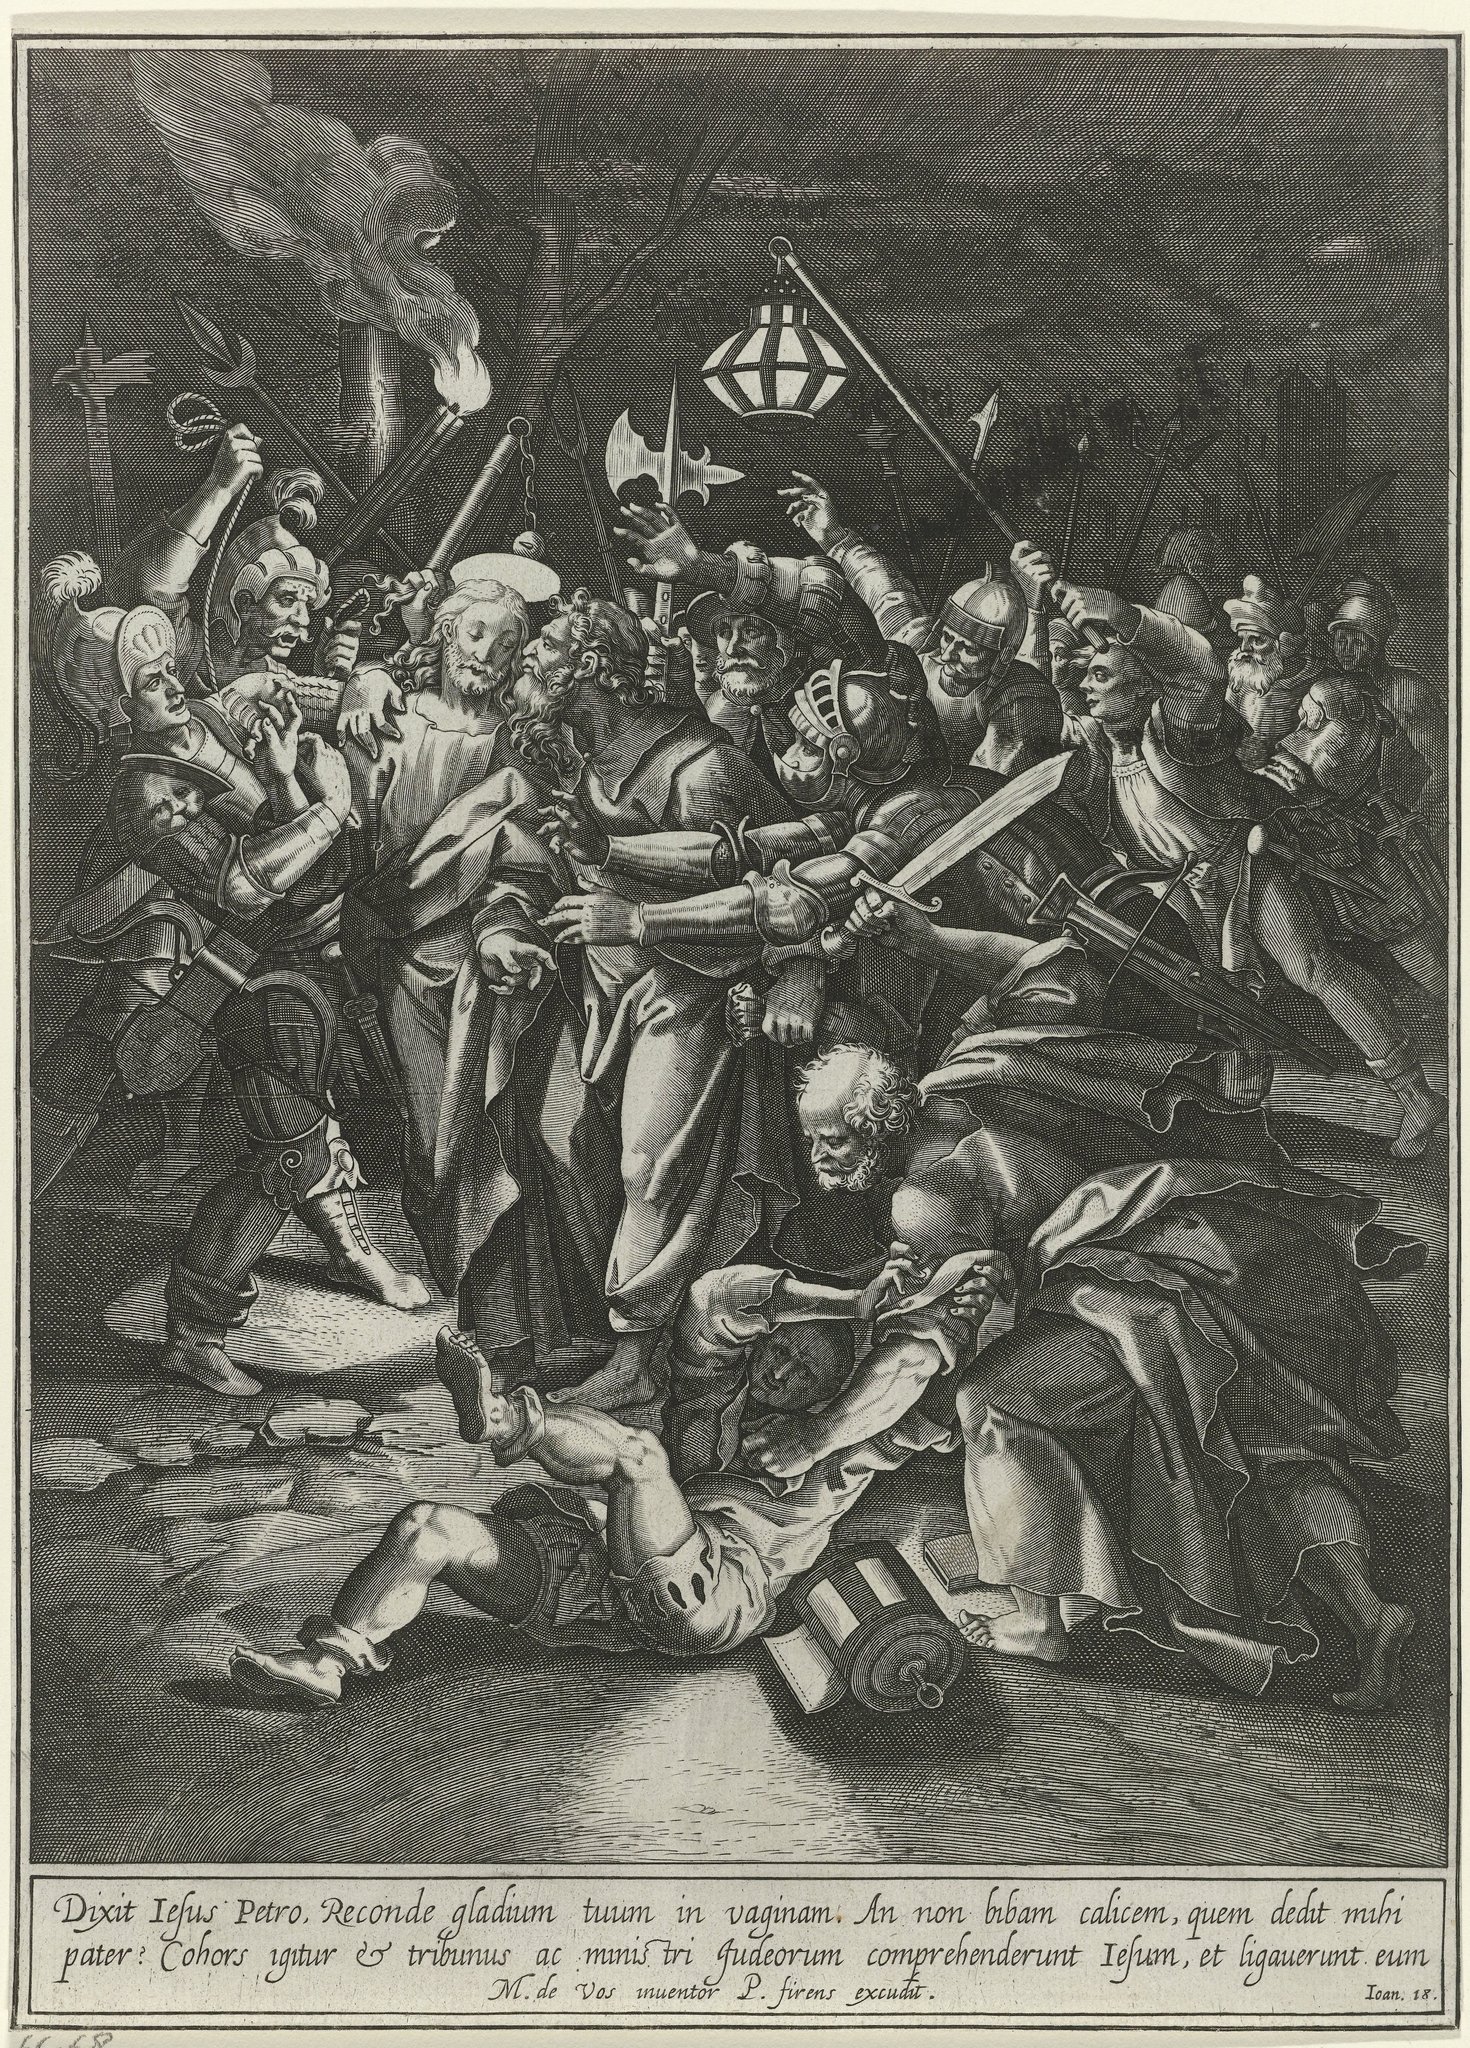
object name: print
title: Passie en wederopstanding van Christus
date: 1590-1638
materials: paper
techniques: engraving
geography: antwerp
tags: the kiss of judas: accompanied by soldiers with torches and lanterns, he kisses christ, the arrest of christ ~ garden of gethsemane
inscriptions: collector's mark: Lugt 2228, collector's mark: Lugt 2760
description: Christus en zijn leerlingen in de hof van Getsemane. Judas kust Christus op de wang. De soldaten omsingelen en arresteren hem. Op de voorgrond tracht Petrus Christus te verdedigen en valt een van de soldaten aan. De prent heeft een Latijns onderschrift met een tekst uit de Bijbel en is de derde prent van een veertiendelige serie over de passie van Christus.